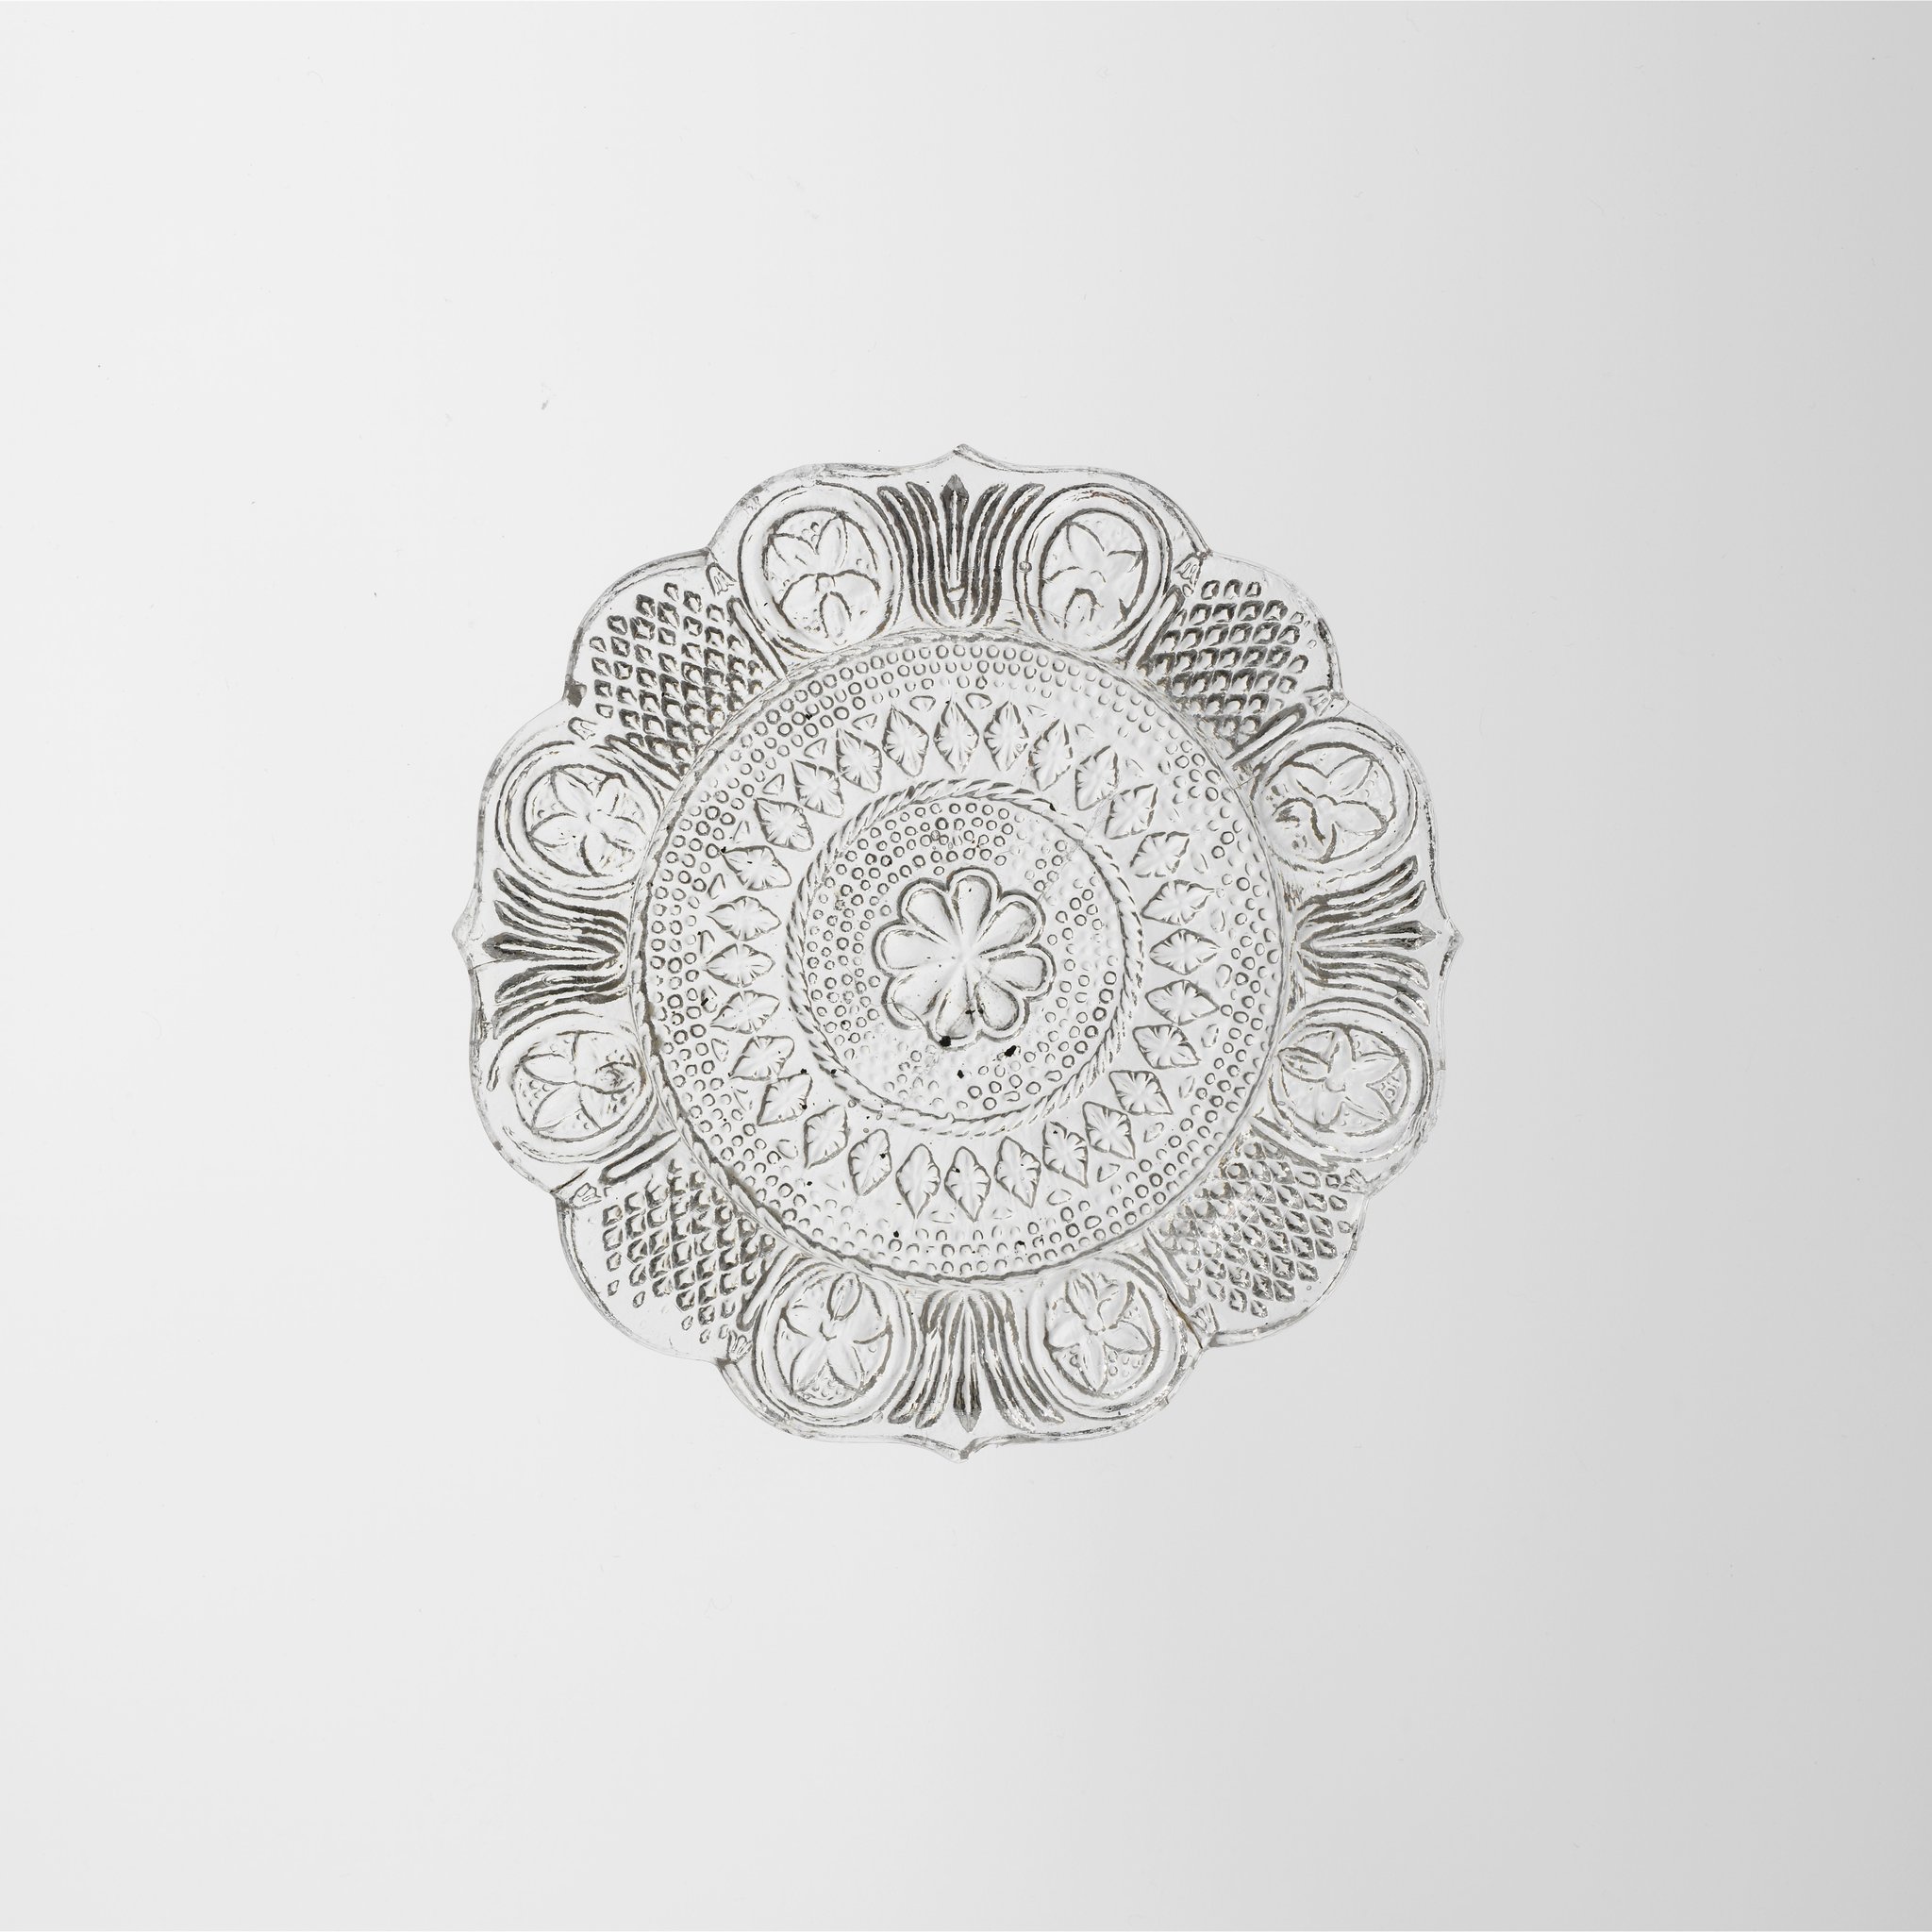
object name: cup plate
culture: american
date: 1830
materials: glass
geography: united states